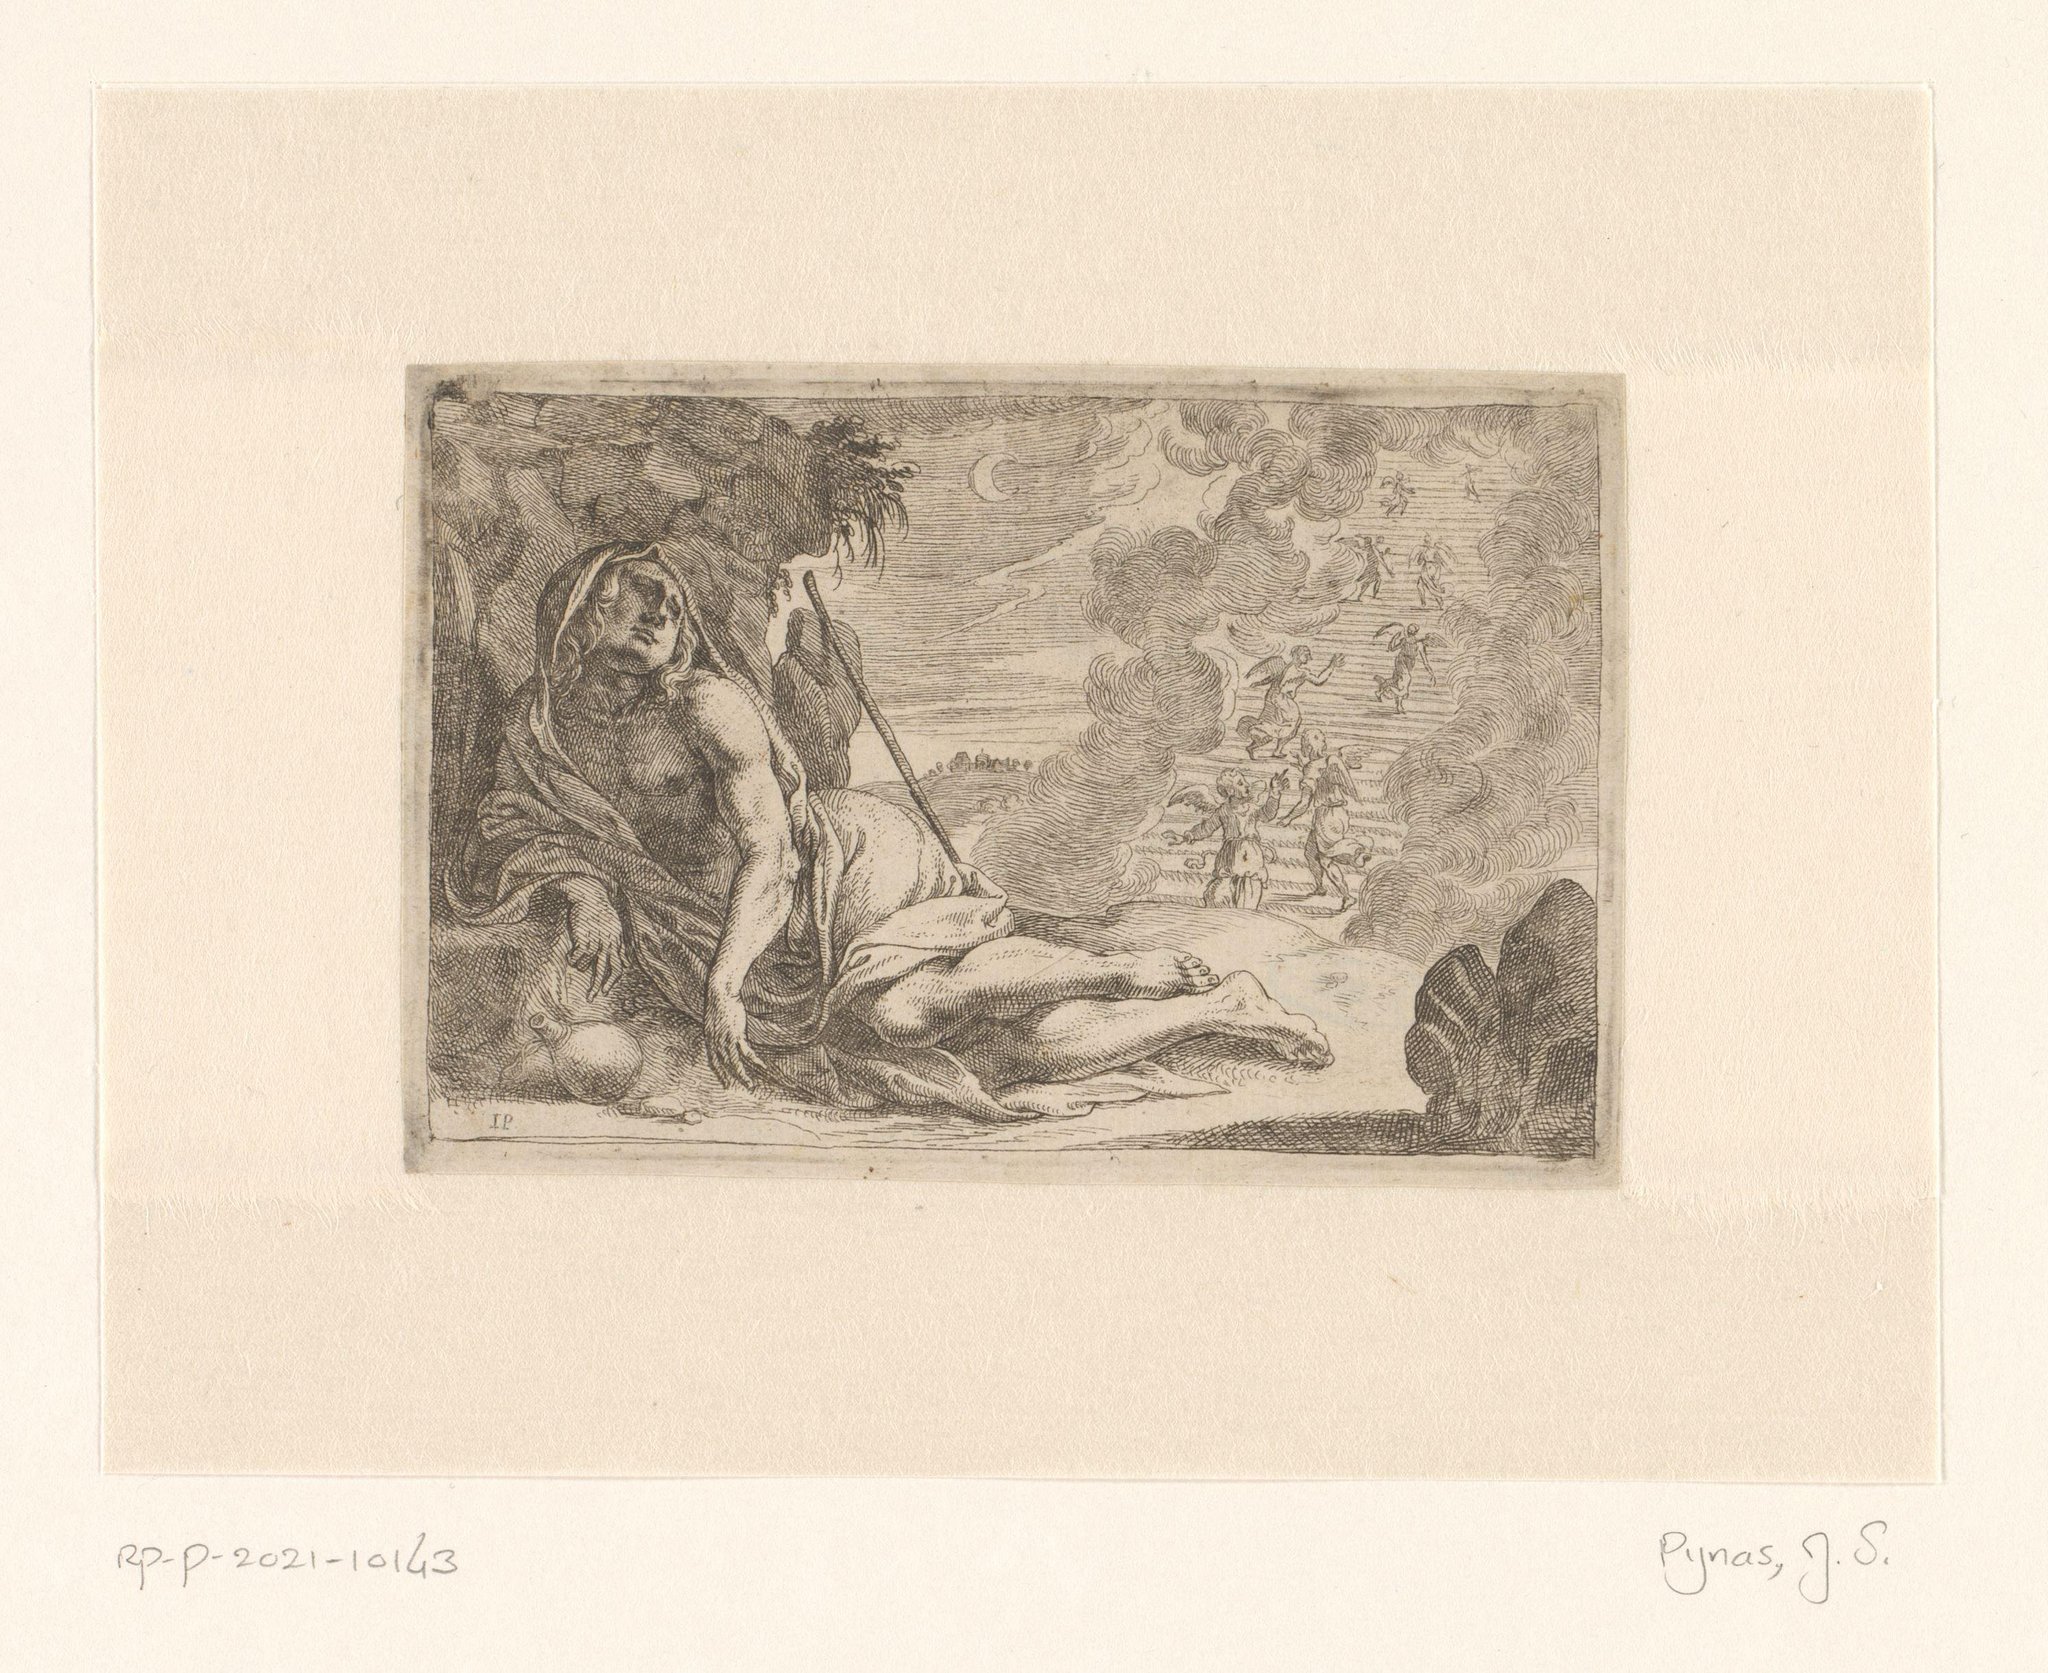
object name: print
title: Jakobs droom in Betel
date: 1592-1631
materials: paper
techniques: etching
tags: the dream of jacob: while sleeping on the ground with a stone for pillow jacob sees a ladder reaching from earth to heaven with angels going up and down; usually with god at the top of the ladder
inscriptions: inscription: ‘[Declaratie?] 4/ Jans: 16’, monogram: ‘IP’, collector's mark: Lugt 2228, inscription: ‘Jacques Pienas’, inscription: ‘JW Holman/ 1868’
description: Jakob ligt, geleund tegen een steen, te slapen in Betel. Op de achtergrond zijn droom. Hij droomt van een ladder naar de hemel waarop engelen omhoog gaan en afdalen.